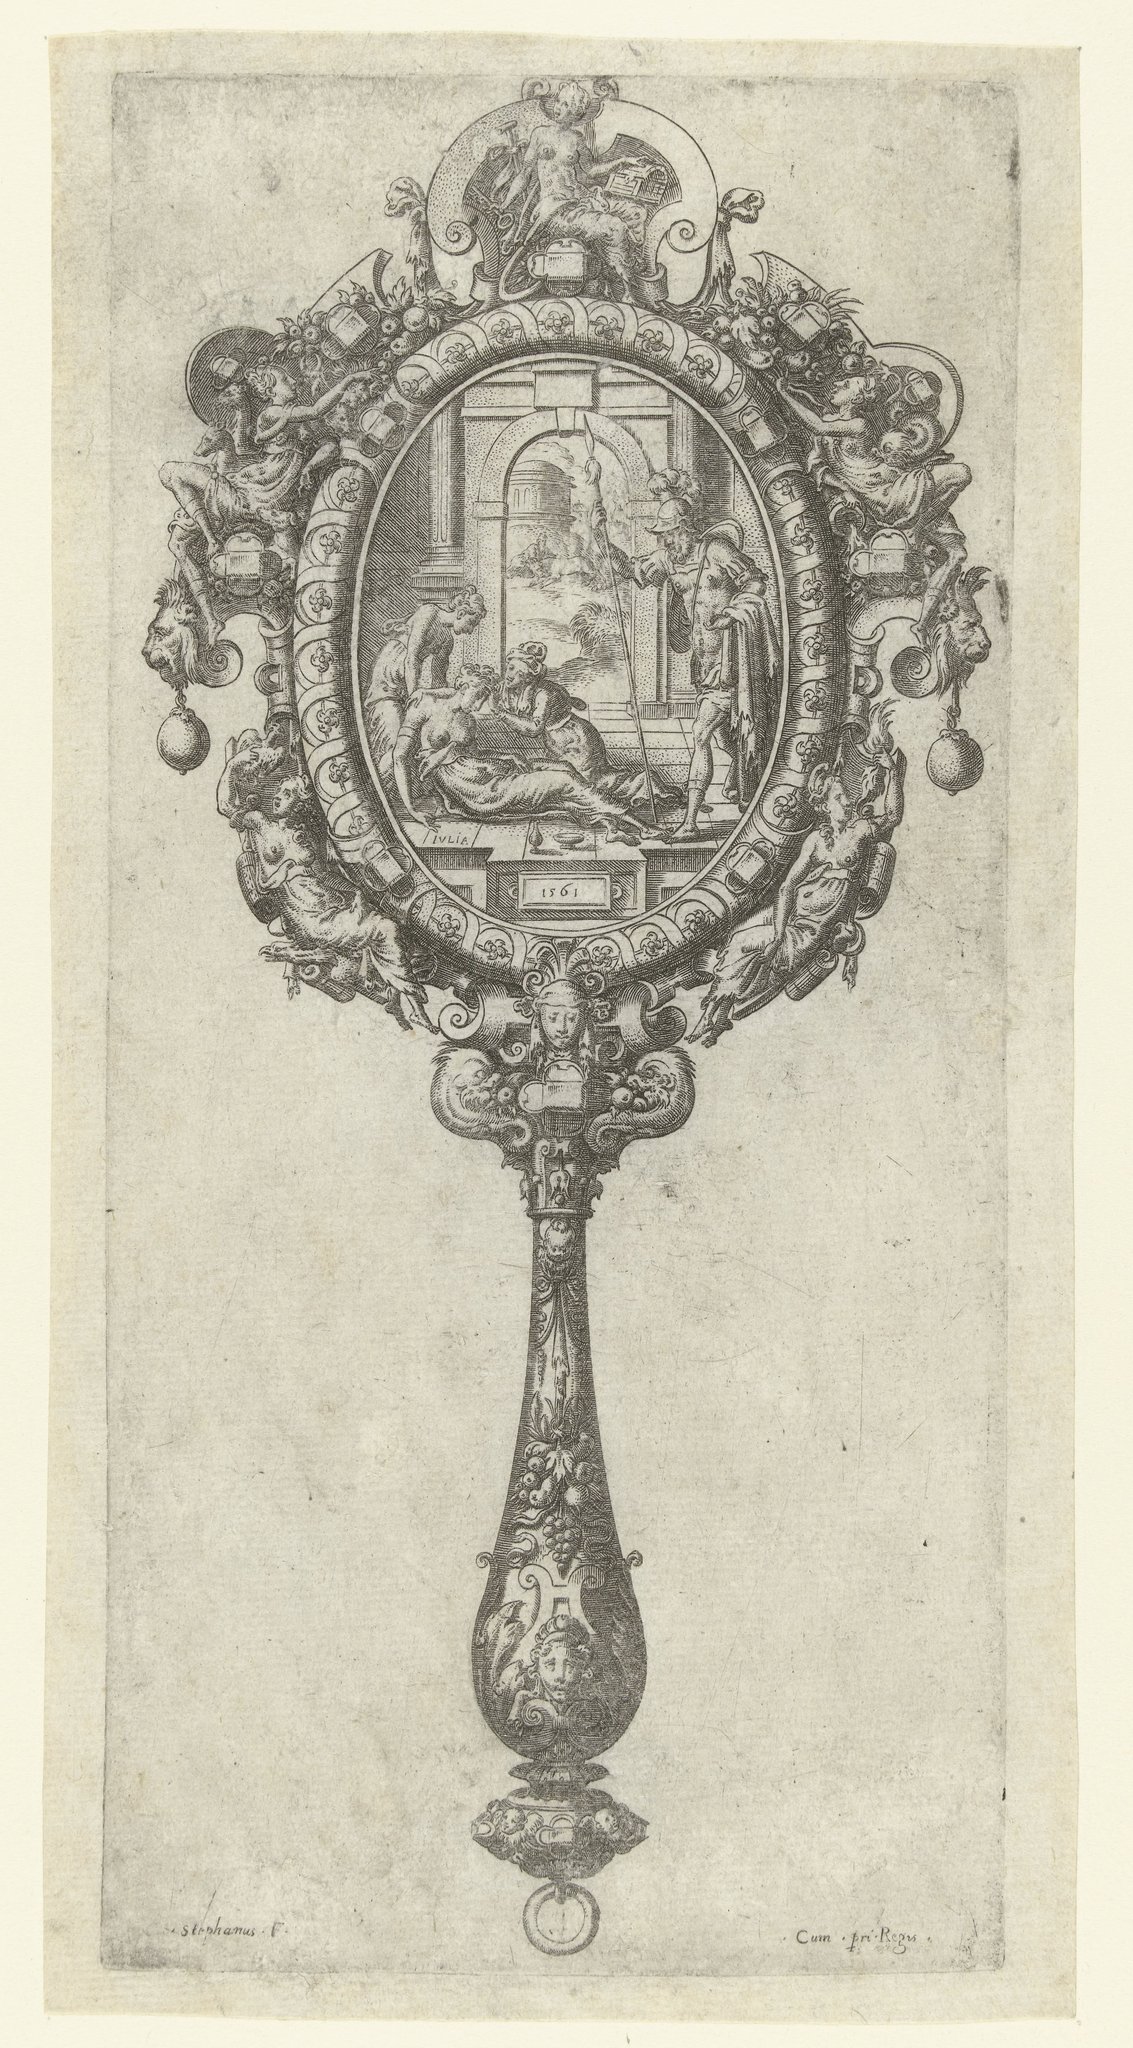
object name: print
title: Spiegel: ovaal met een voorstelling van de dood van Julia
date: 1561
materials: paper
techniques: engraving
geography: france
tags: mirror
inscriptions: date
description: Ovaal, in een omlijsting van rolwerk met grotesken, figuren, mascarons en guirlandes. Aan het handvat hangt een ring. Eén blad uit een serie van twee.